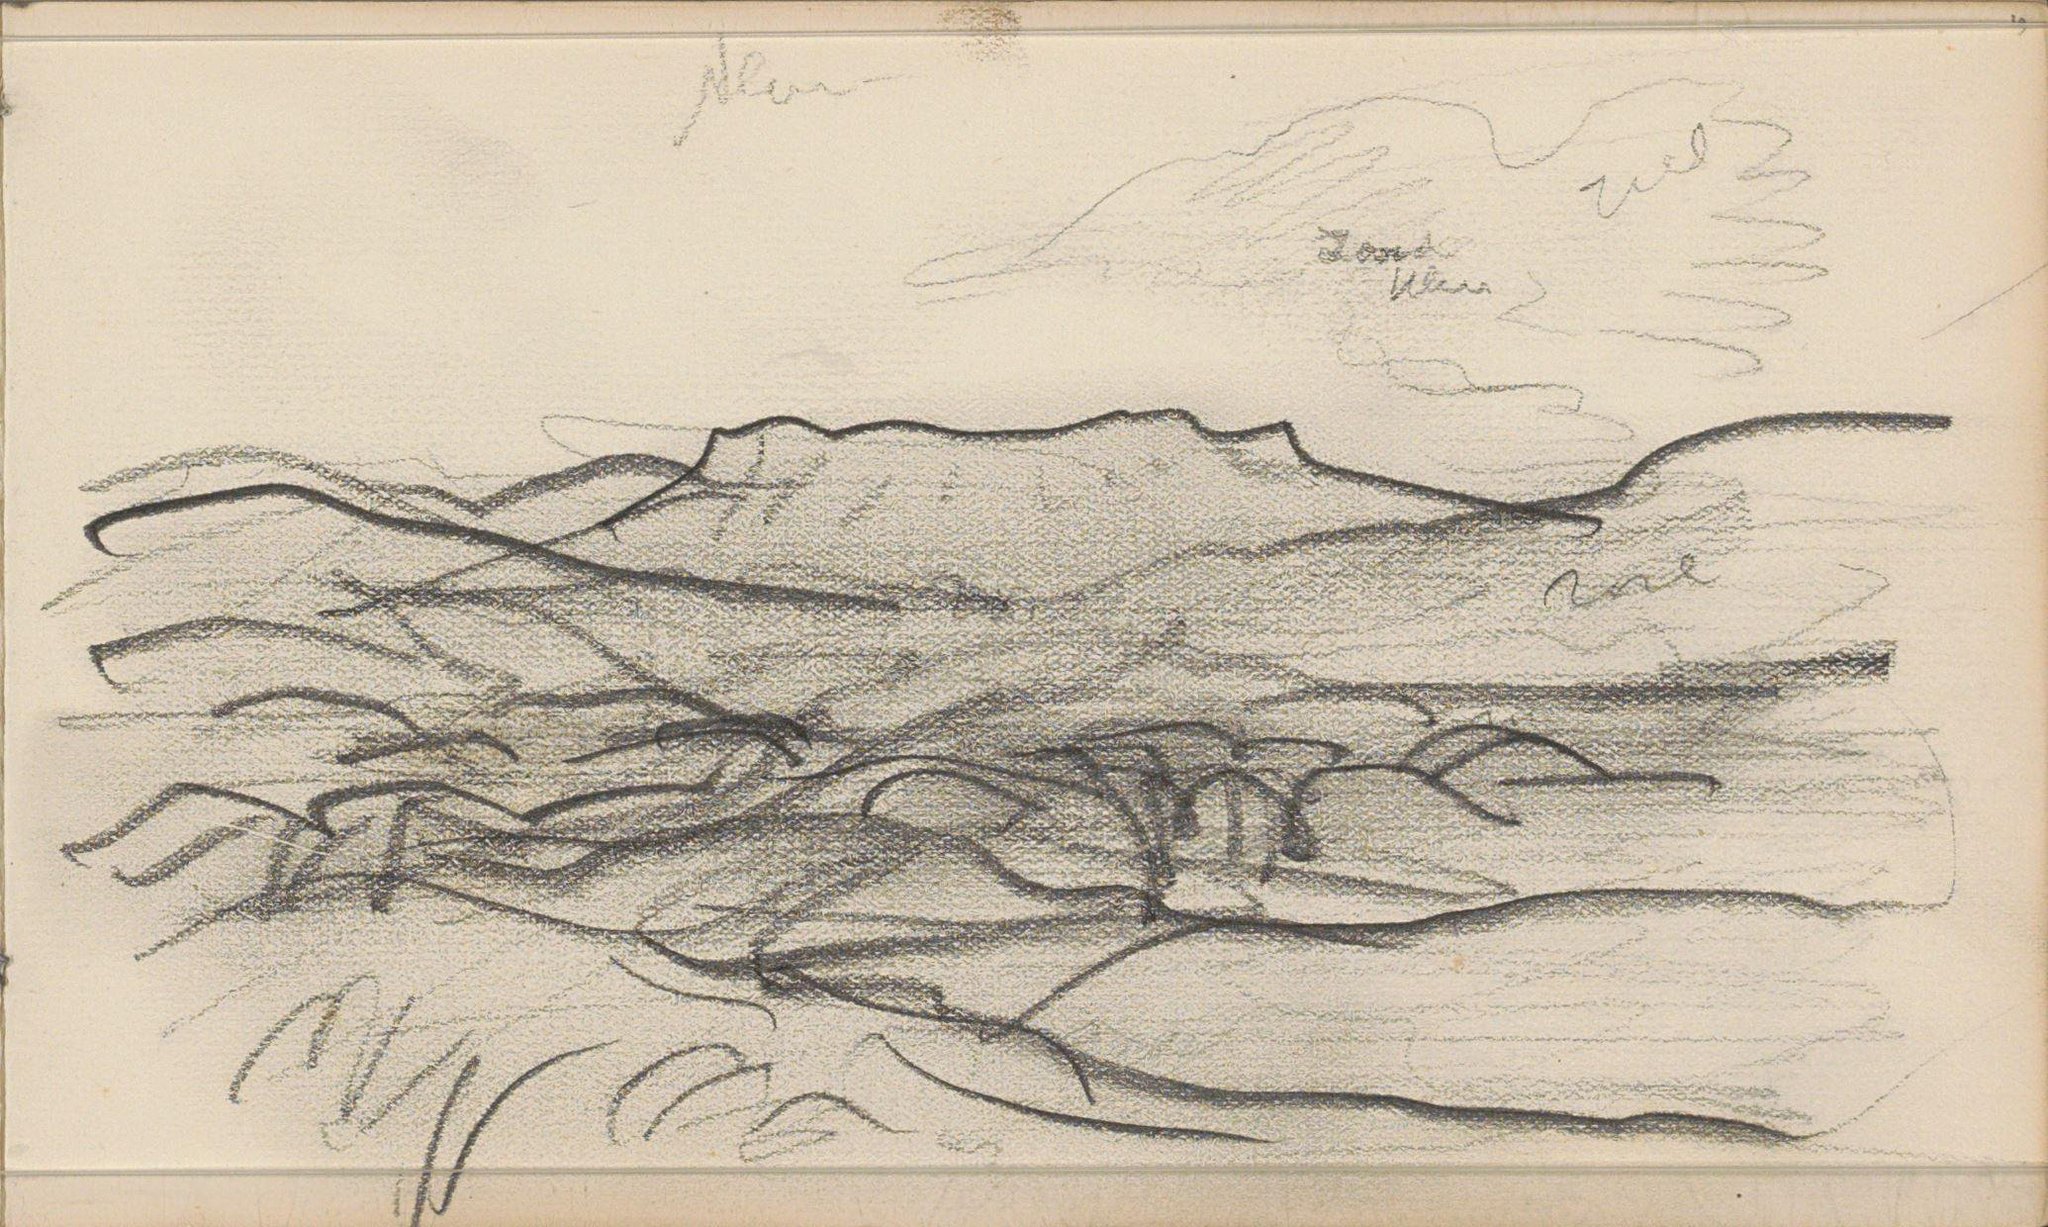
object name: sketchbook leaf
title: Atlasgebergte bij Algerije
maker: marius bauer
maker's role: draughtsman, print maker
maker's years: 1867-1932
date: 1922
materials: paper, pencil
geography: algeria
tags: mountains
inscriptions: kleurnotitie, handgeschreven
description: Pagina 19 uit een schetsboek met 31 bladen.